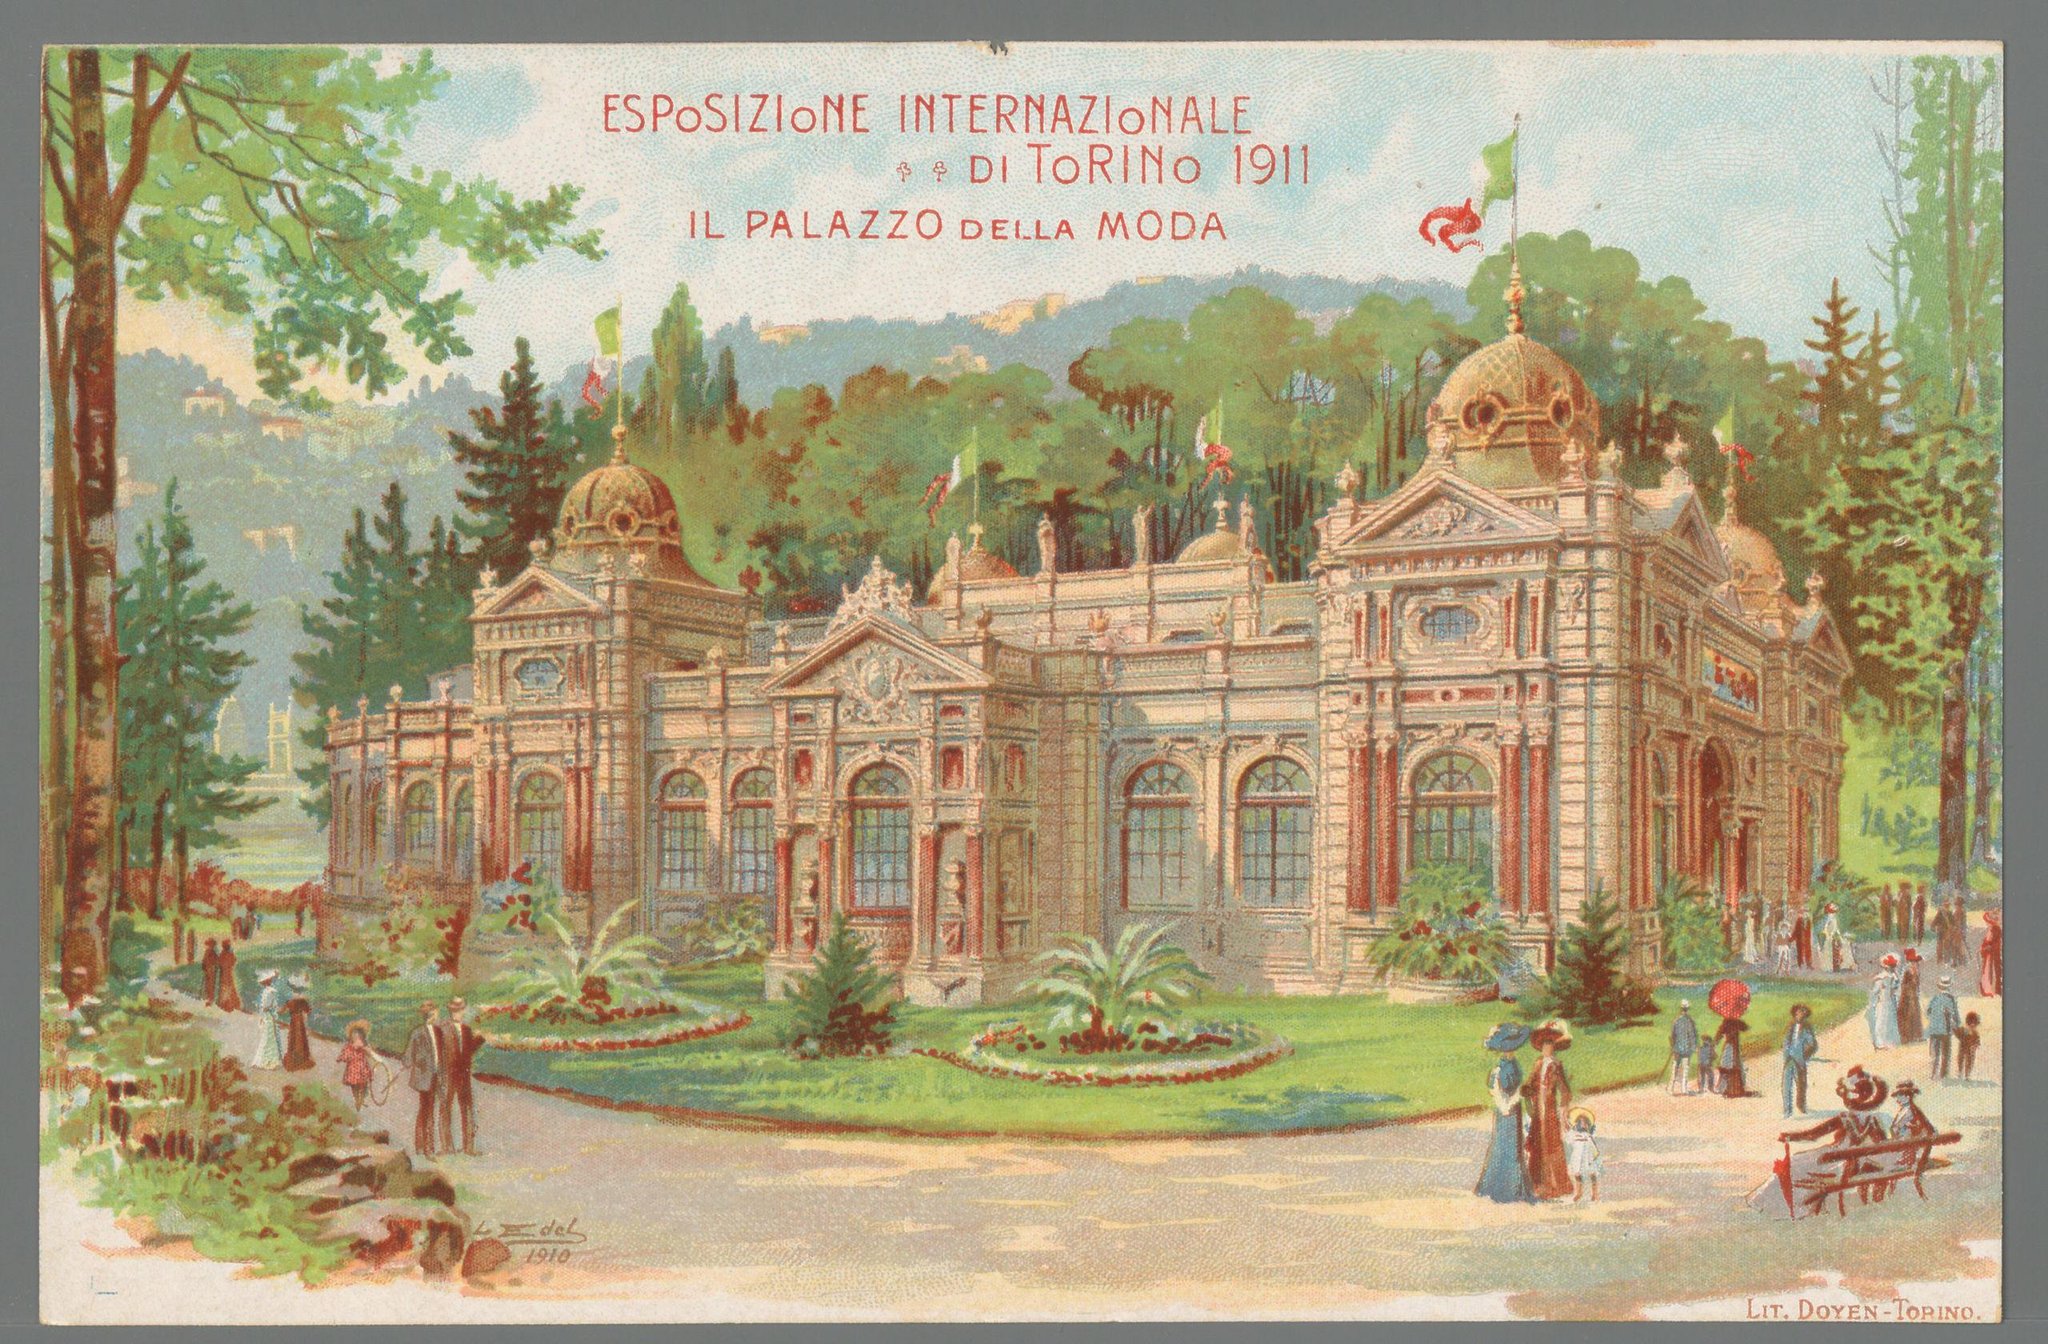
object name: print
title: Il Palazzo della Moda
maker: Anonymous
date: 1910-1911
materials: cardboard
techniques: lithograph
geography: turin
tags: world fair, world exhibition, palace, turin international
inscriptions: monogram: ‘LE’